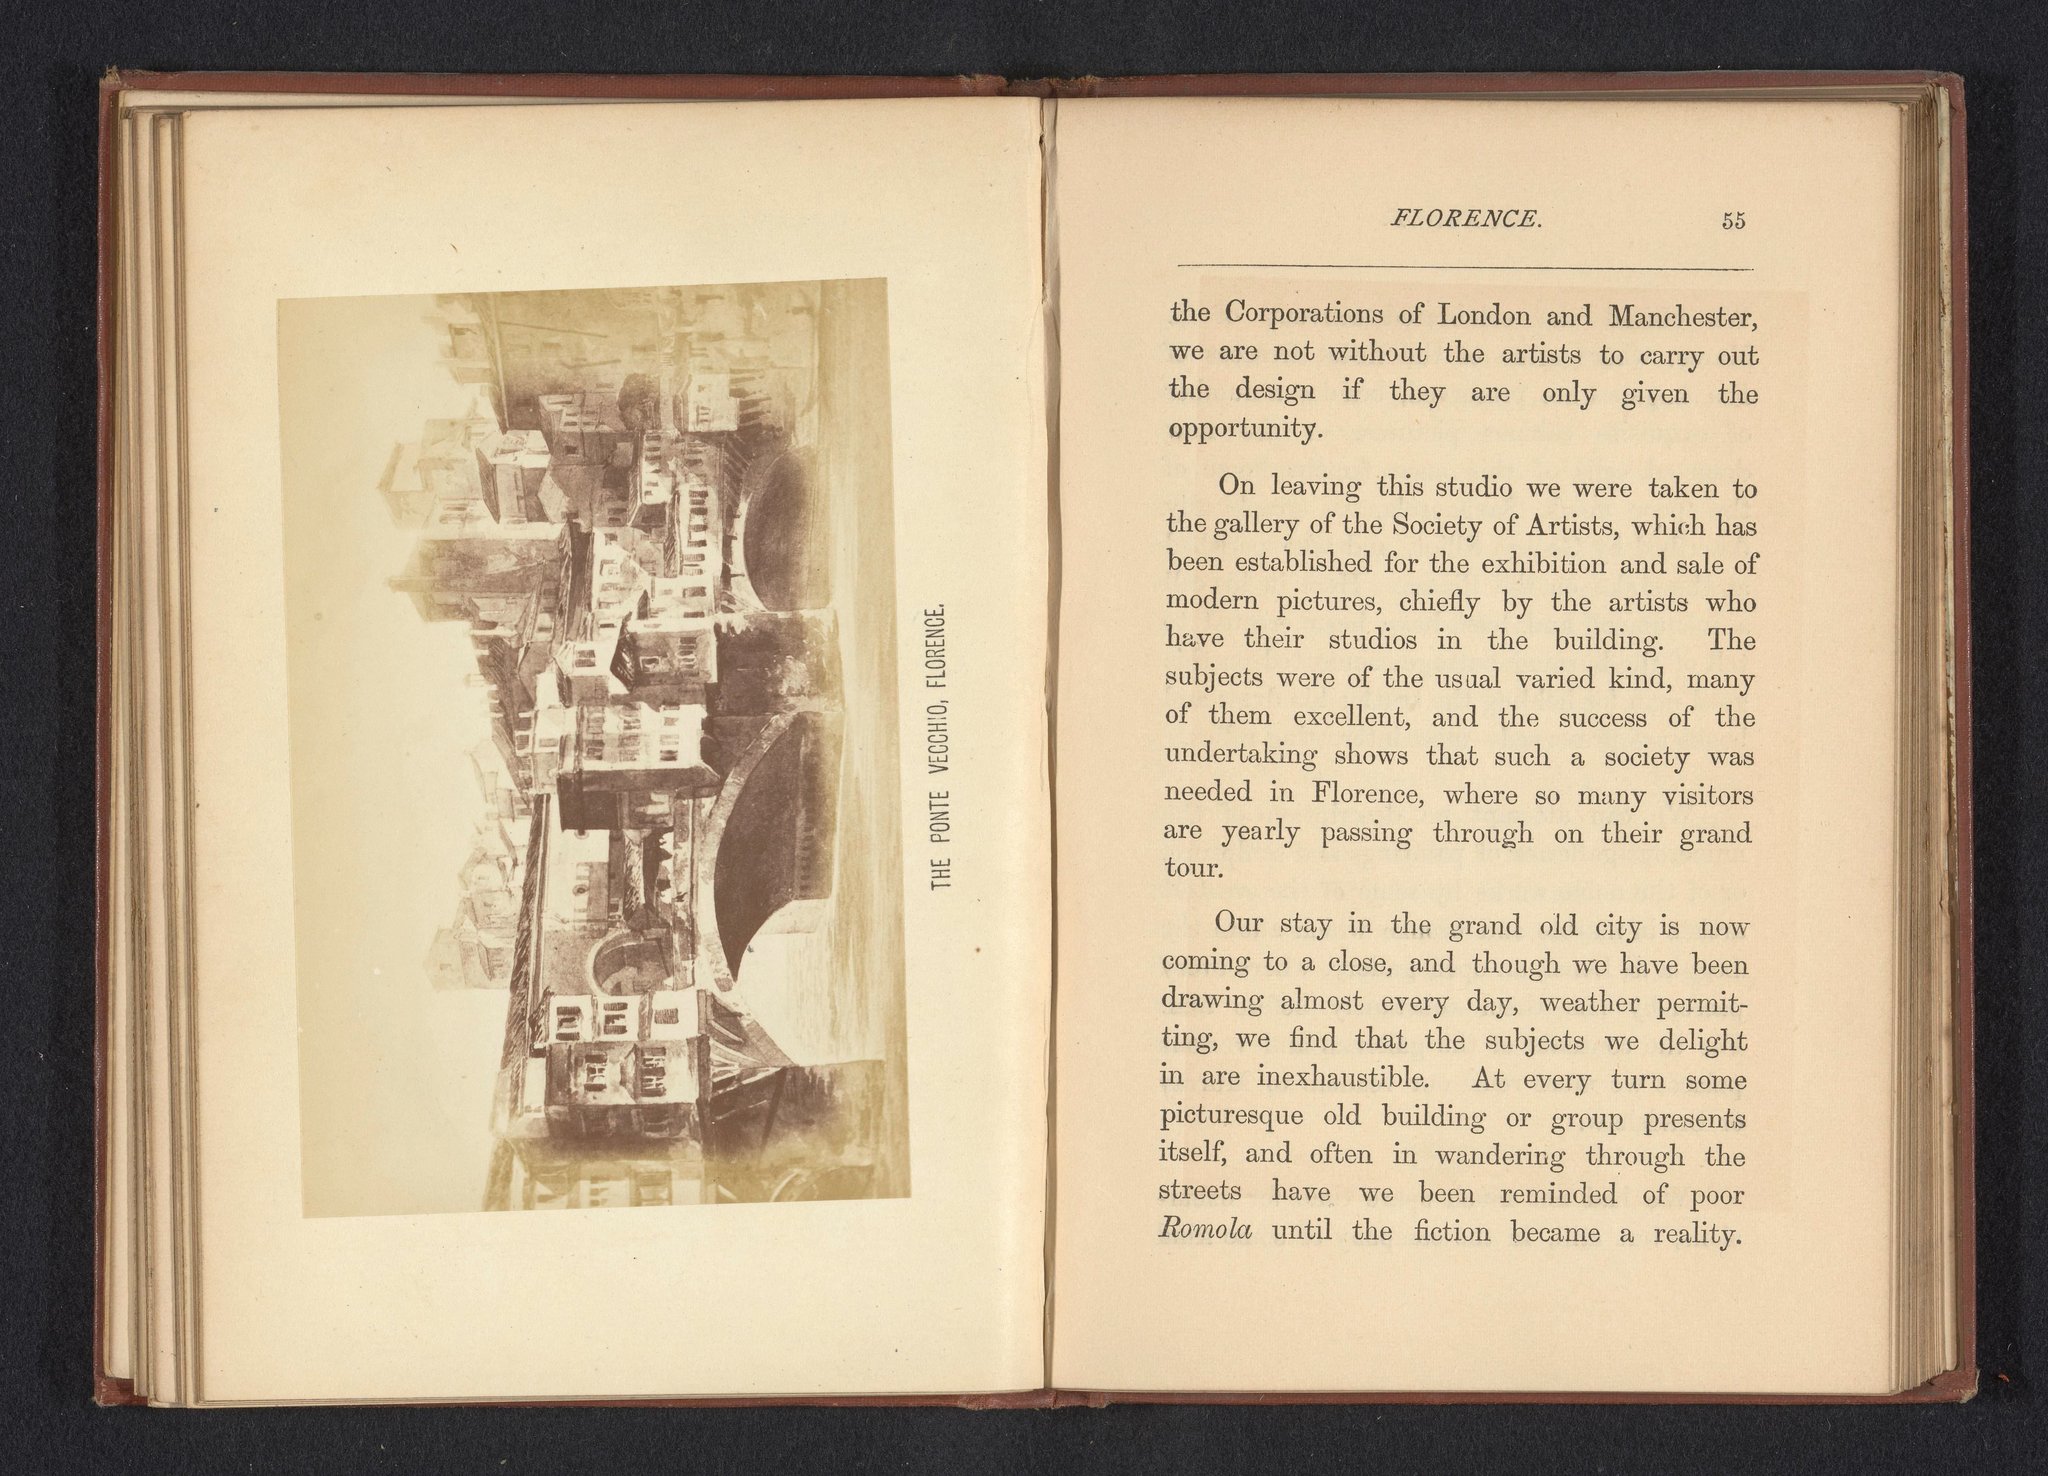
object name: reproduction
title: The Ponte Vecchio, Florence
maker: j. greer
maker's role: fotograaf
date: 1867-1877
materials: photographic support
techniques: albumen print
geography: florence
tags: bridge in city with structures, i.e. shops, houses, e.g. ponte vecchio in florence